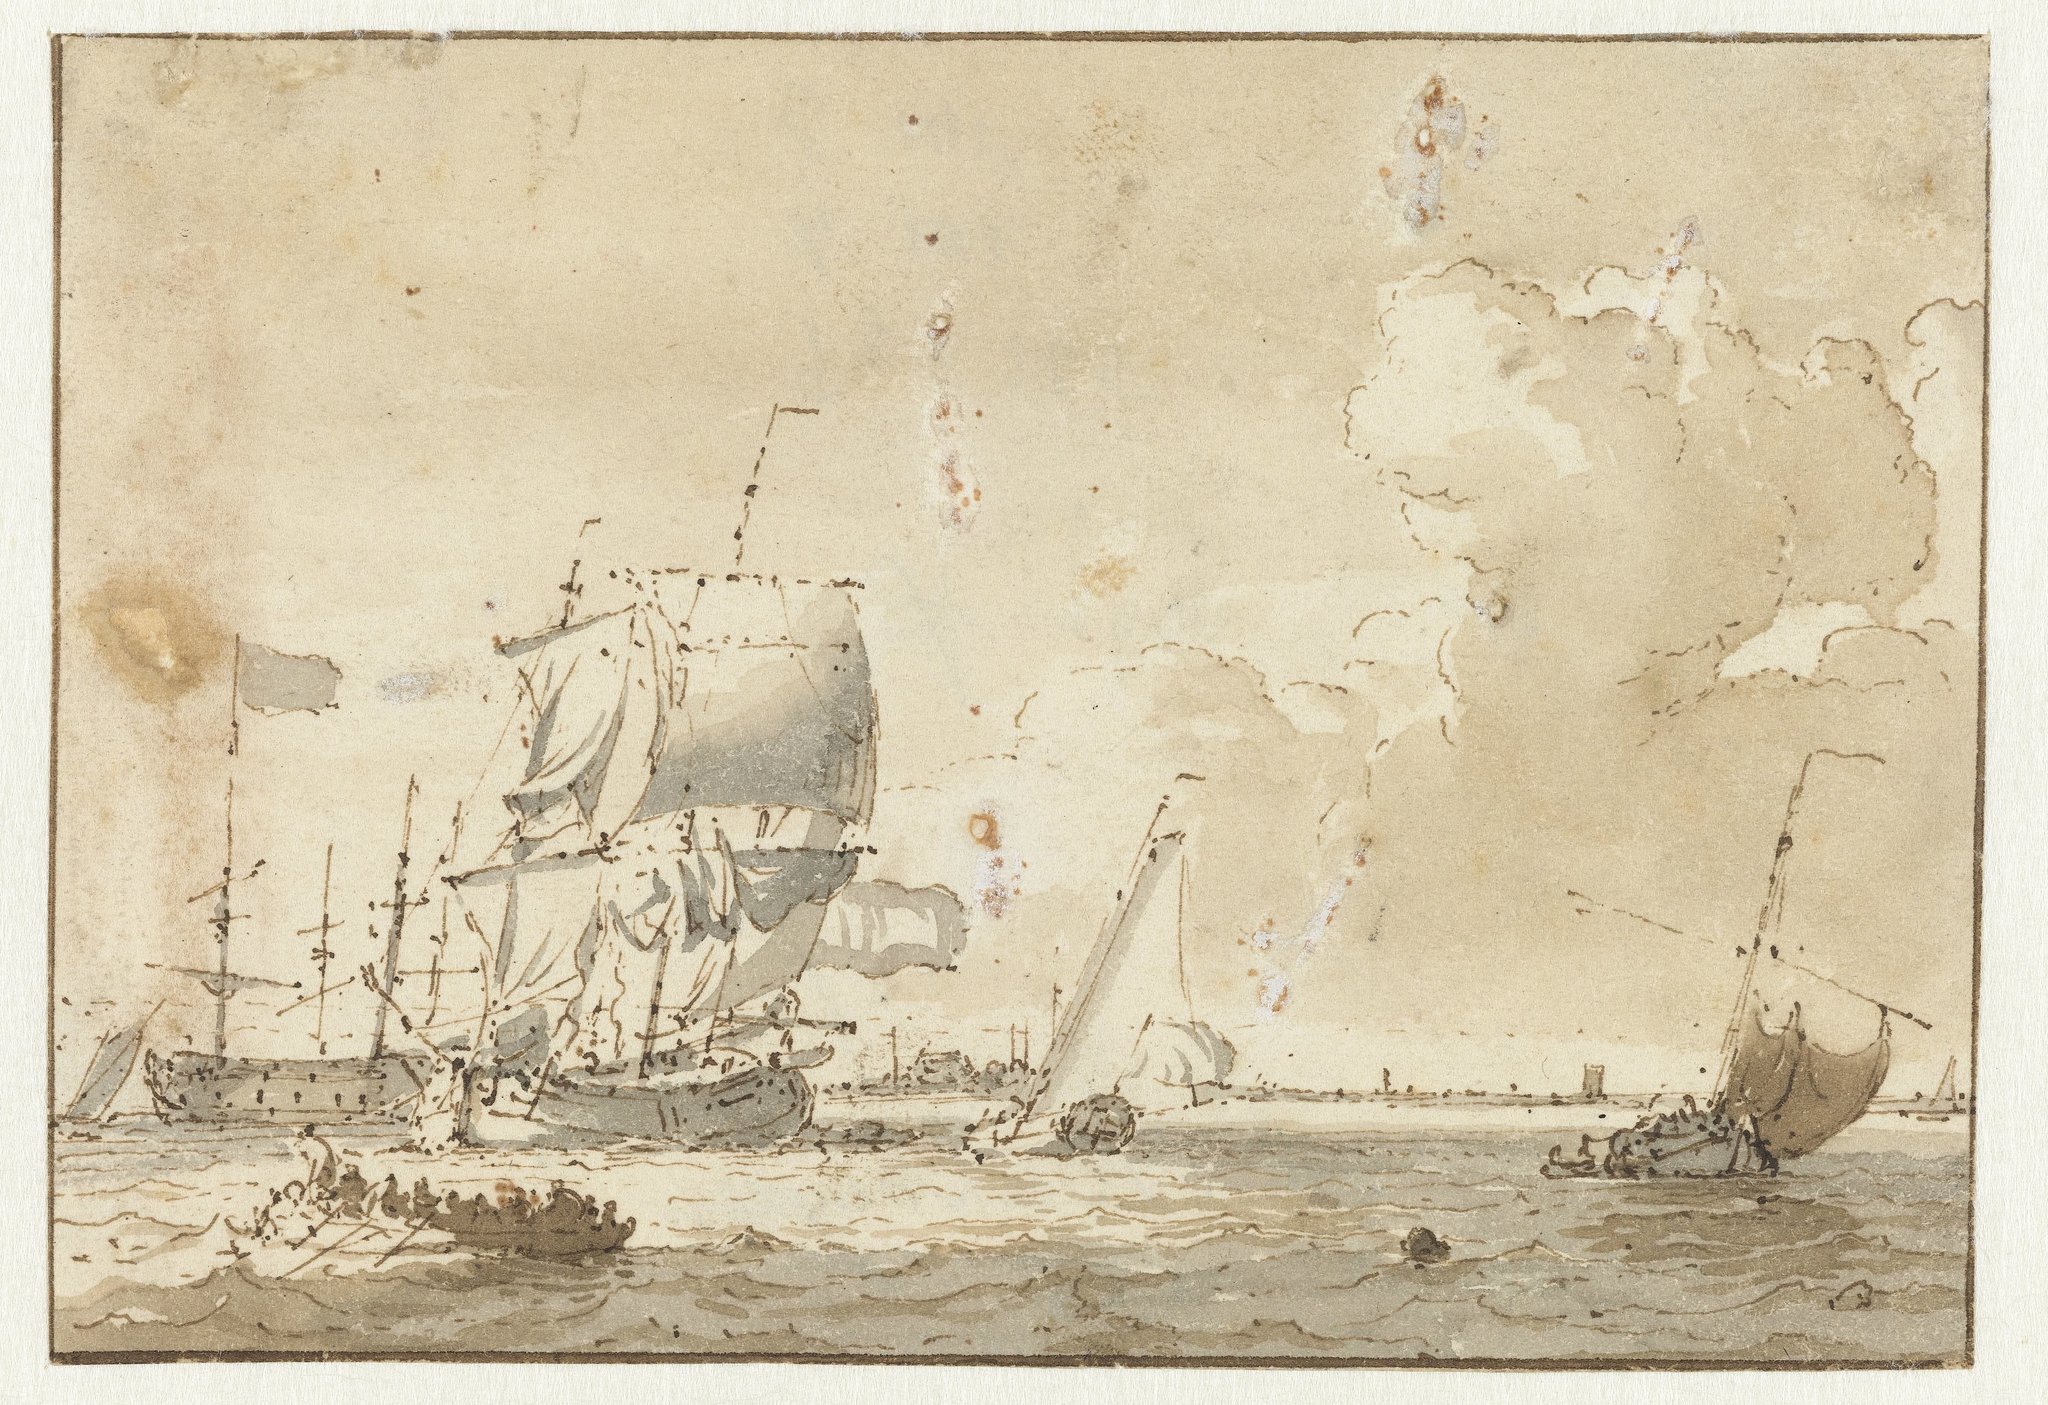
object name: drawing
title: Schepen op het water voor een stad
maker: ludolf bakhuysen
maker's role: draughtsman, print maker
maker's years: 1631-1708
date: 1641-1708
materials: chalk, graphite, ink, paper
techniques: brush, pen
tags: sailing-ship, sailing-boat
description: Schepen op het water met links op de voorgrond een sloep.